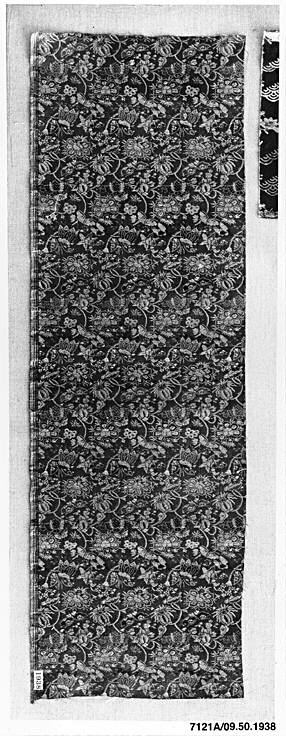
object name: piece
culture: japanese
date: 1801-1900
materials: silk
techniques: brocade